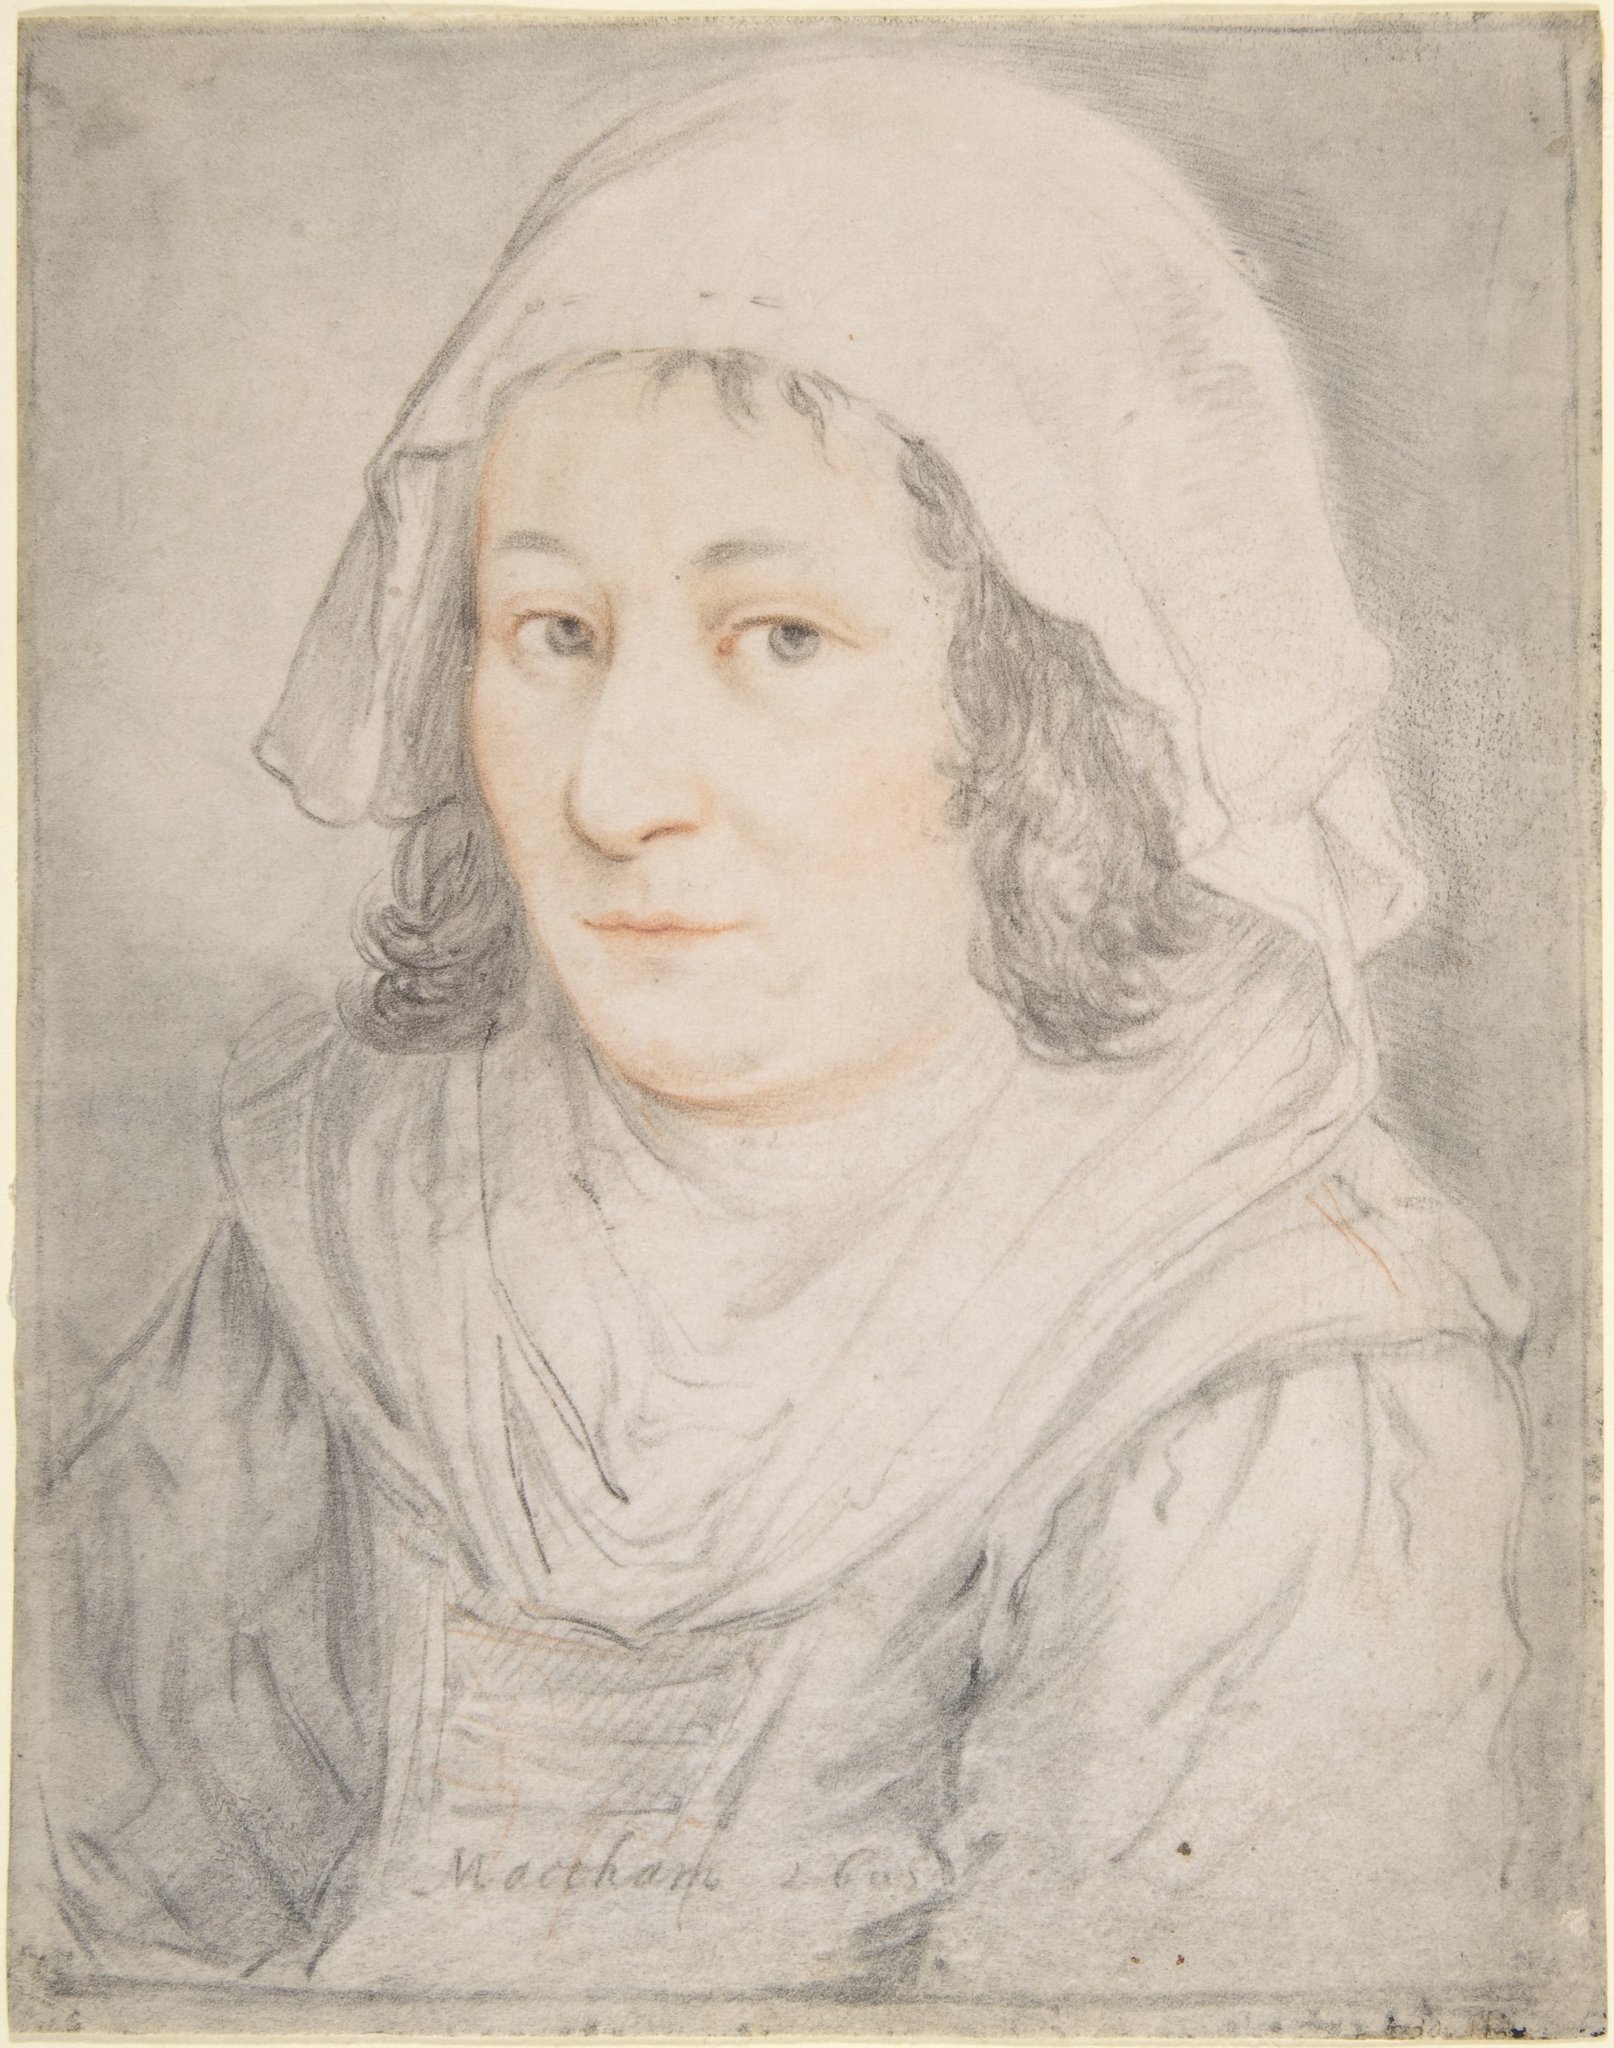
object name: drawing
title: Half-figure of a Woman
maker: jacob matham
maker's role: artist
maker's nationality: netherlandish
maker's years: 1571-1631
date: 1605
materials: chalk, parchment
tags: portraits,women